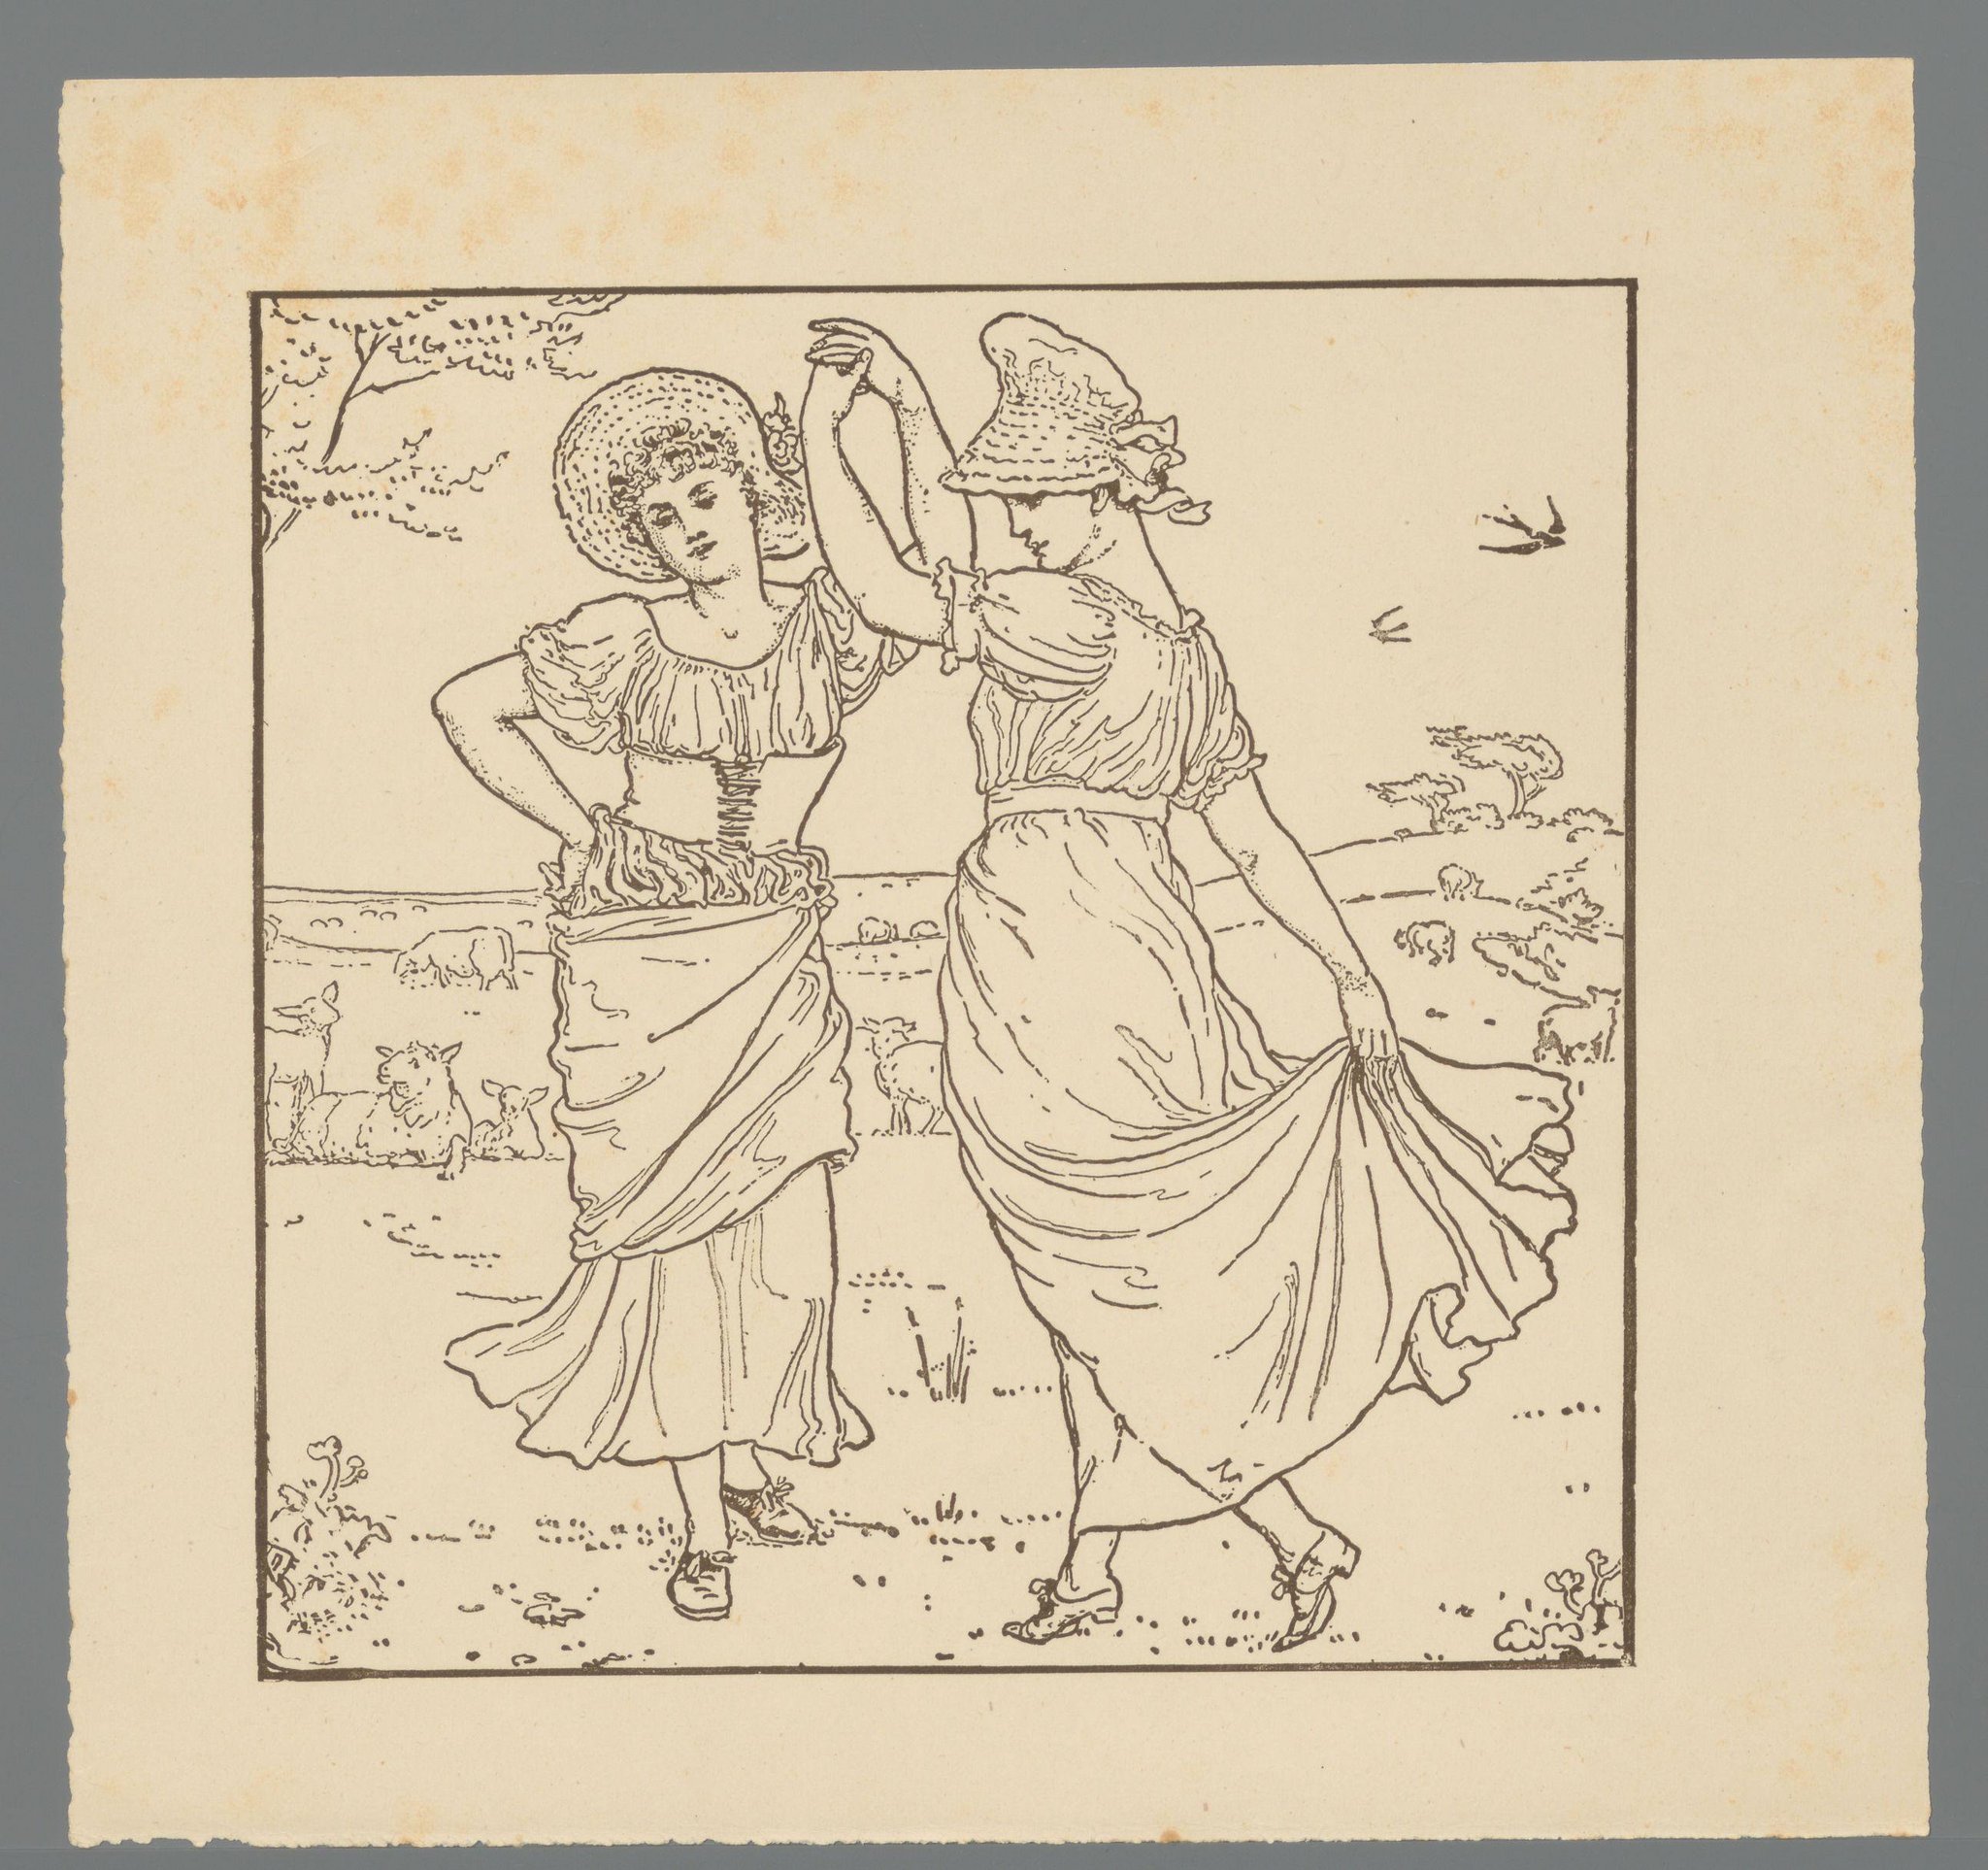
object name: print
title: Twee dansende vrouwen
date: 1887-1927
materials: paper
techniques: engraving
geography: london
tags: dancing, meadow, pasture, adult woman (+ two persons)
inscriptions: collector's mark: Lugt 2228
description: Prent uit: Walter Crane's painting book. Londen: Routledge & Sons, 1887. Of een latere uitgave. Dit boek bevat twaalf voorstellingen die in kleur en lijntekening zijn gedrukt om te gebruiken als (in)kleurboek. De voorstellingen zijn afkomstig uit eerdere werken van Crane.